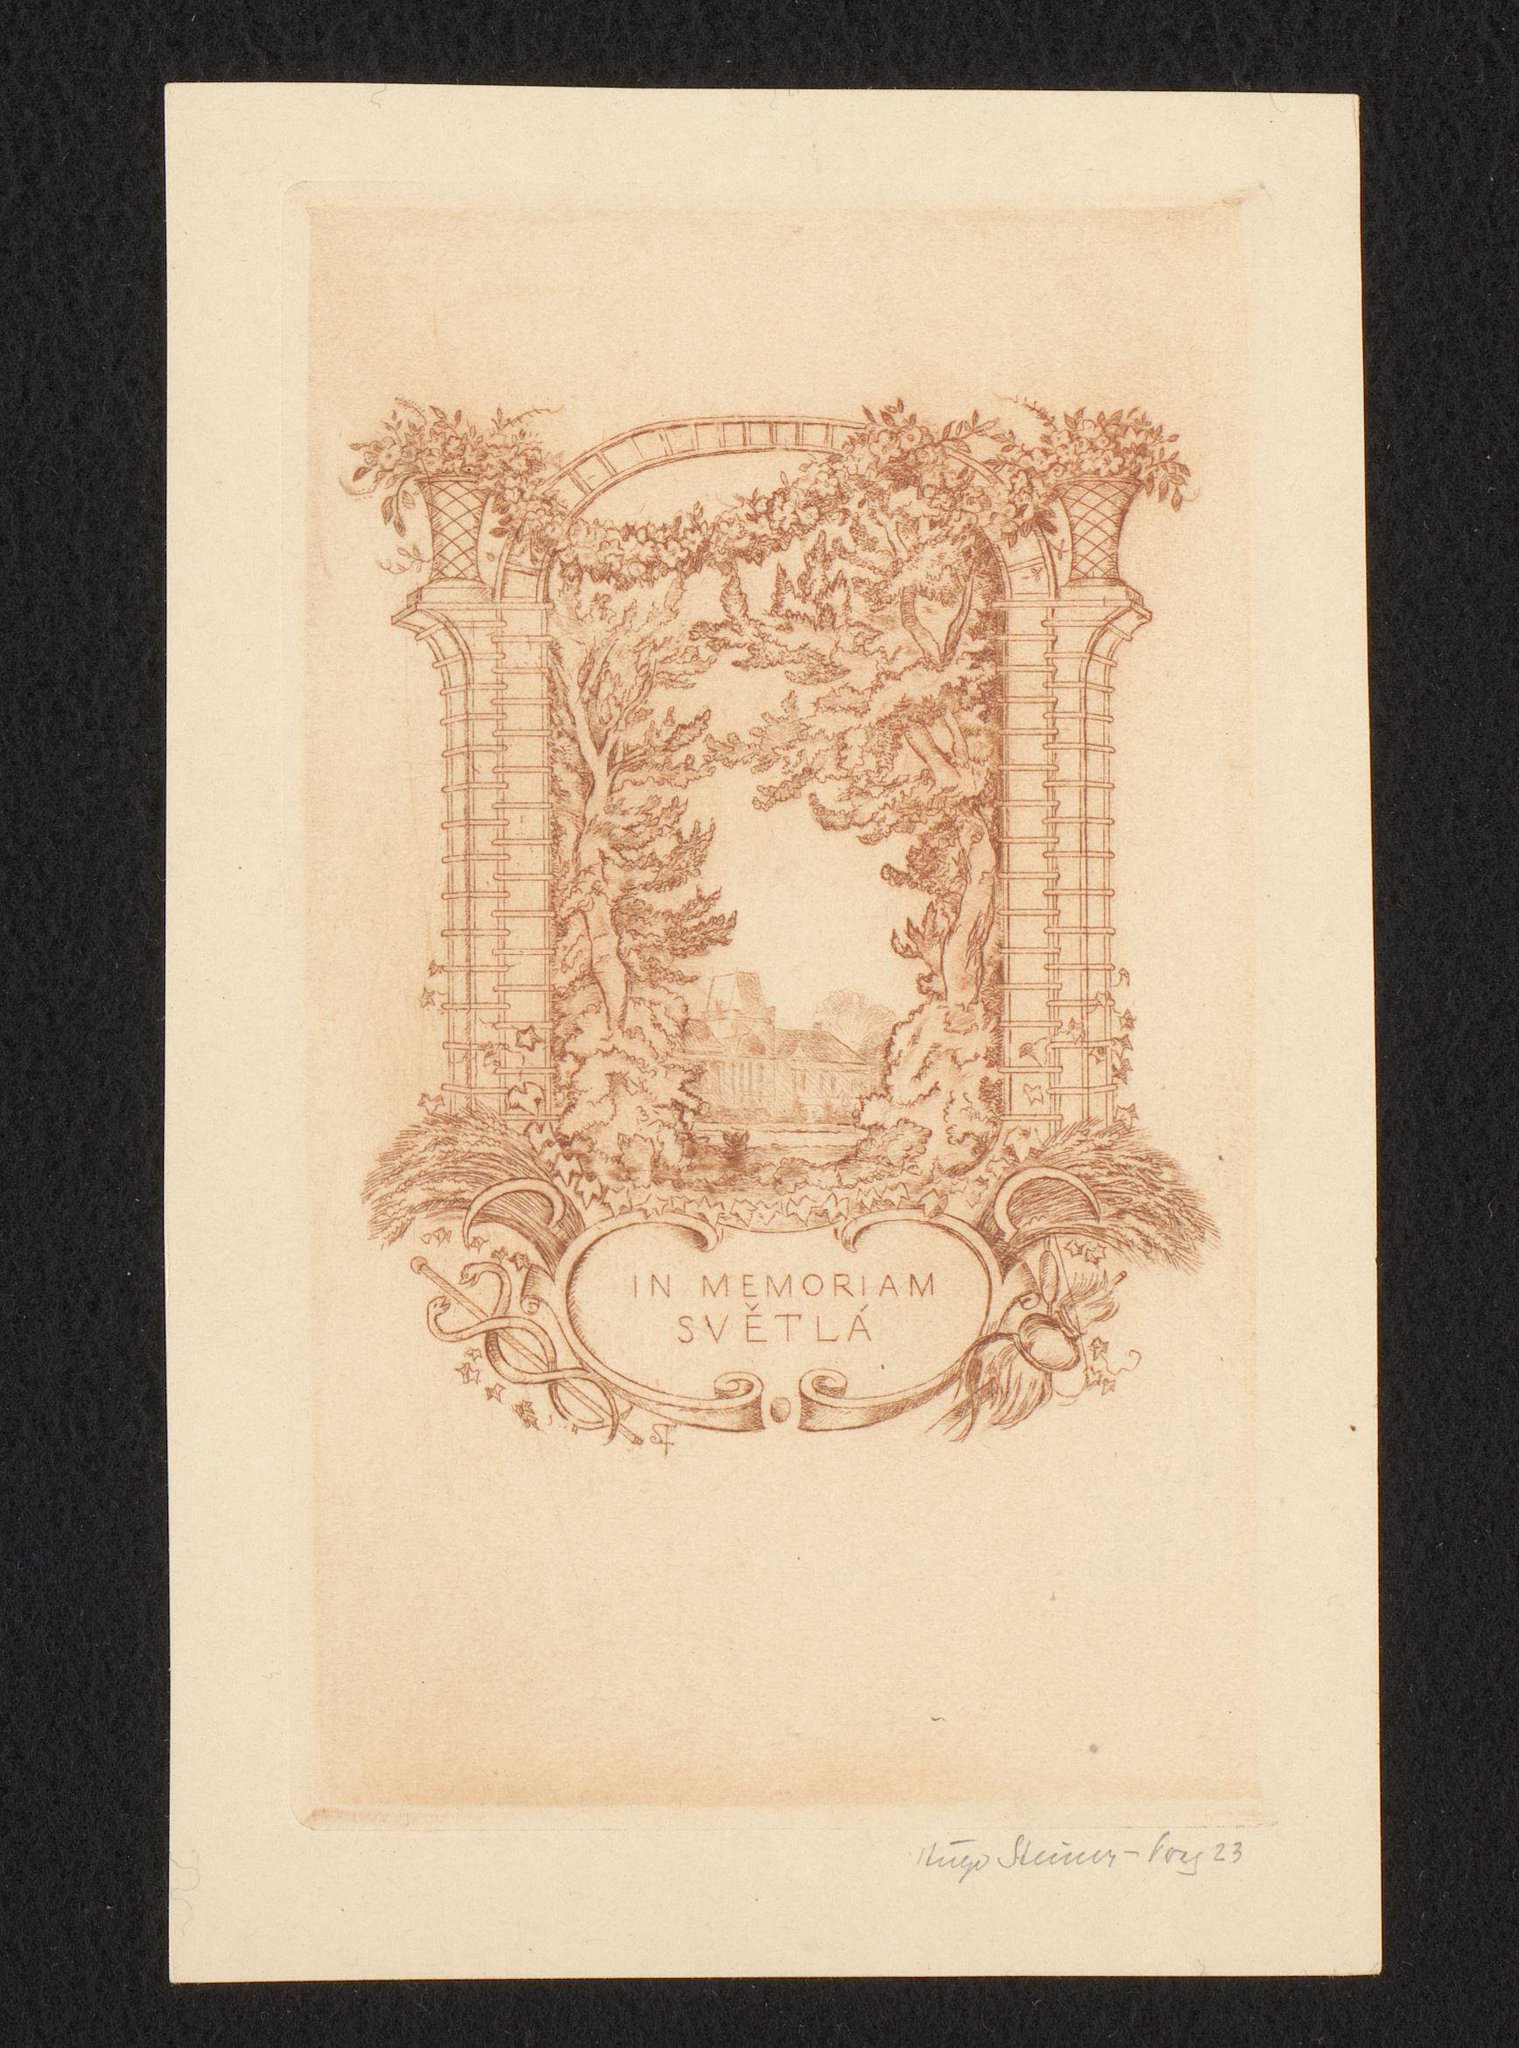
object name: print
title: Herdenkingskaart voor Světlá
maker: hugo steiner-prag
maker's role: illustrator, pedagoog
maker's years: 1880-1945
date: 1923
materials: paper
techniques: etching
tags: 'in memoriam'-card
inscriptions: date